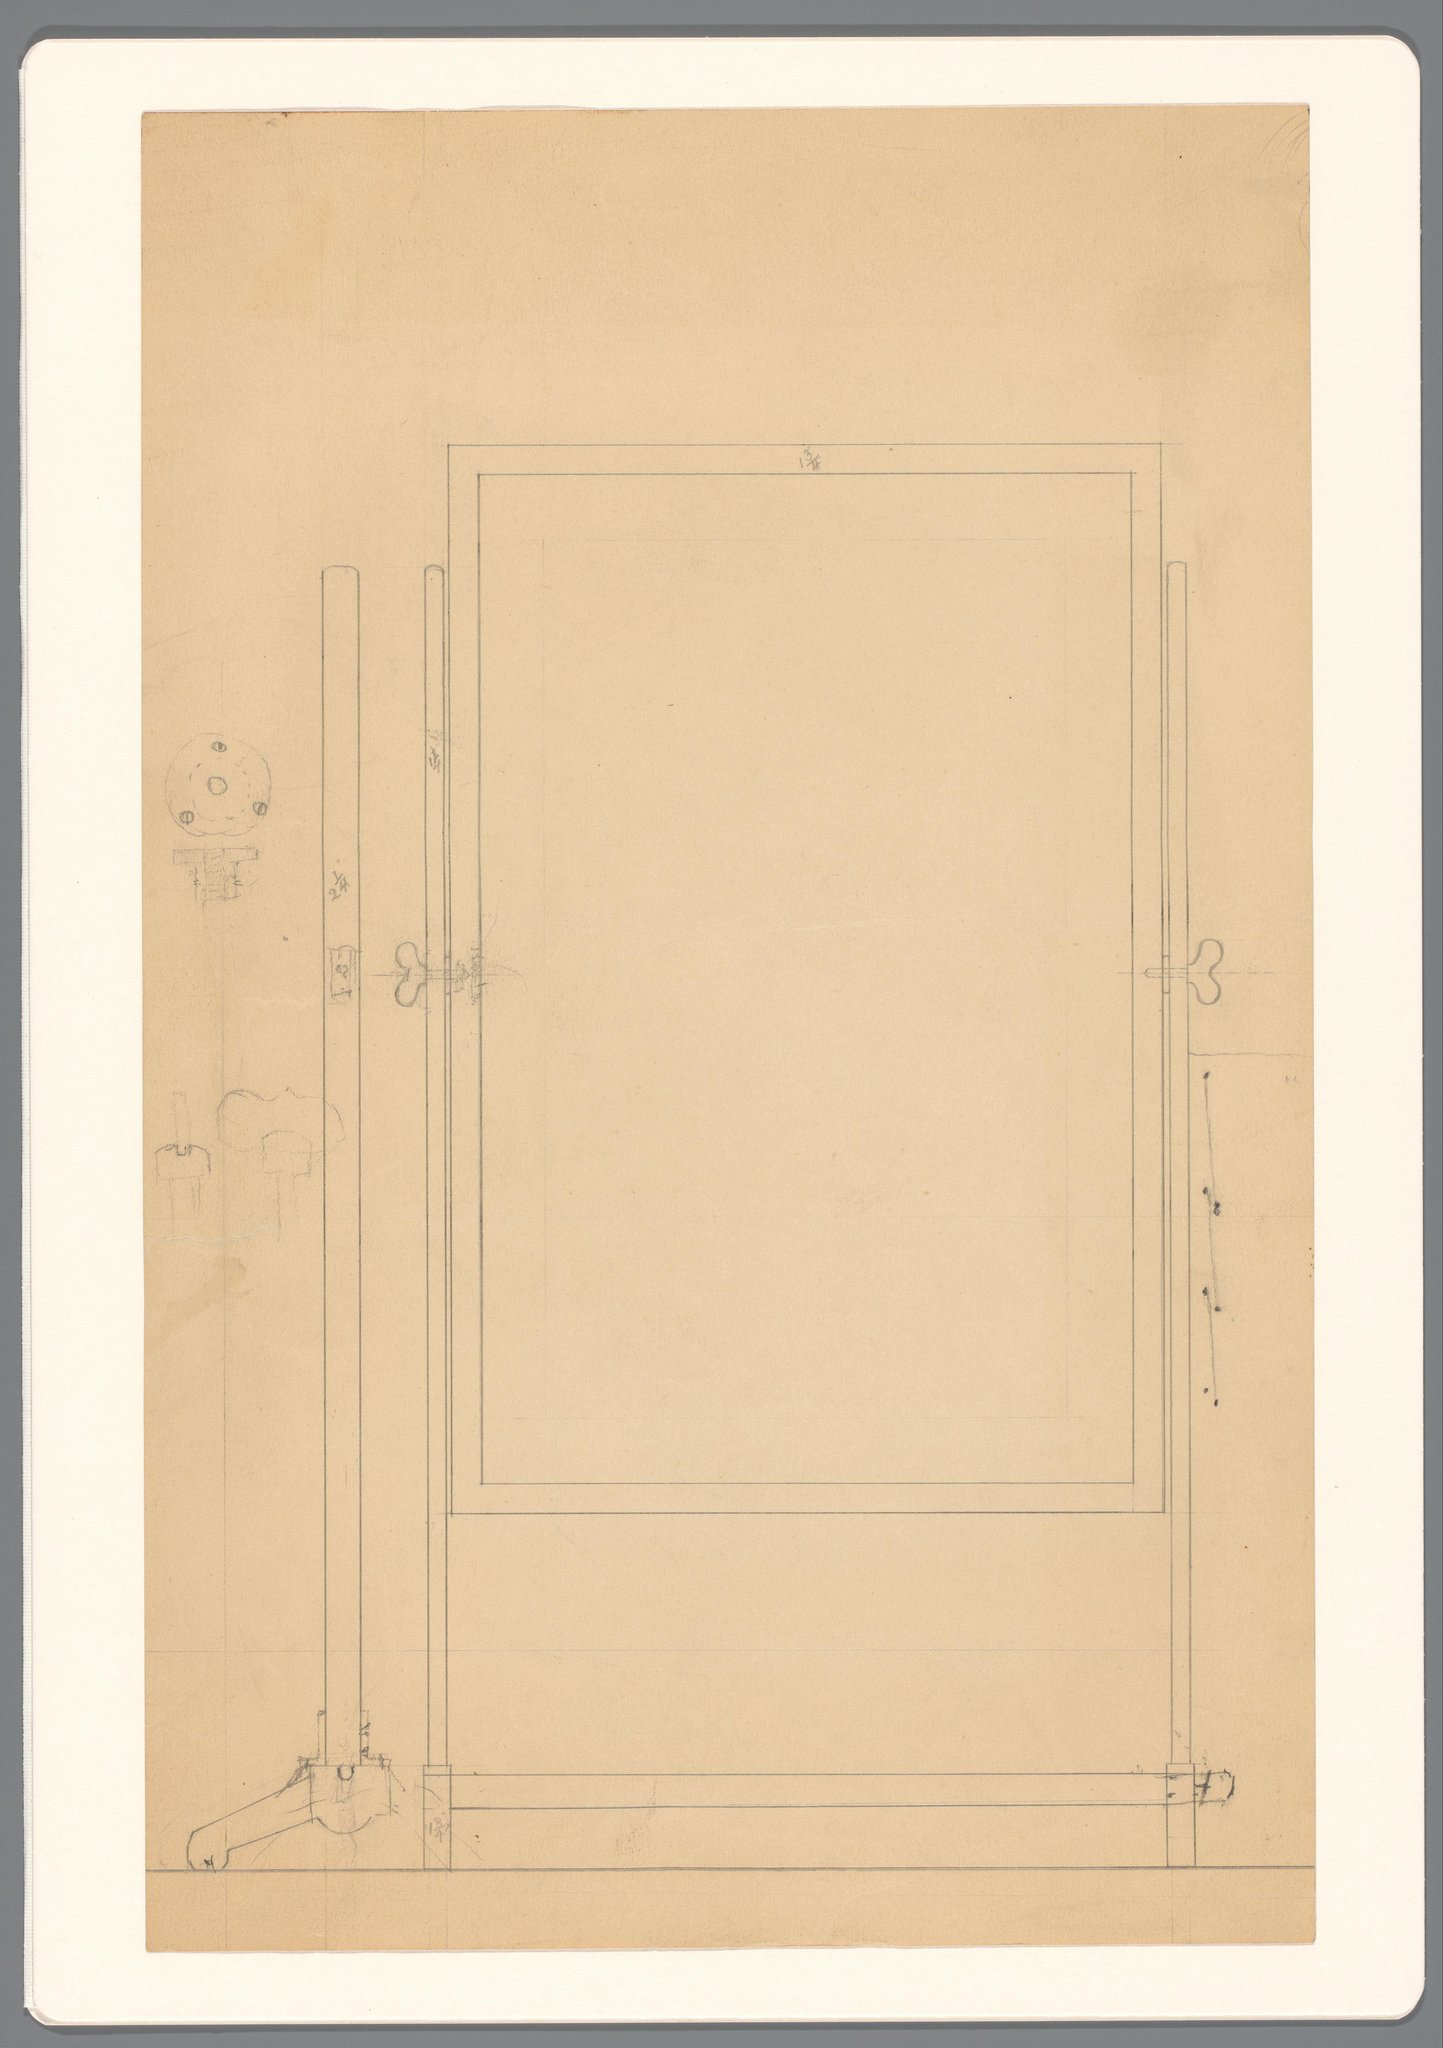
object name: drawing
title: Ontwerp voor een verstelbaar haardscherm, voor en zijaanzicht en details. Verso: Details van haardschermen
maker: b. winghofer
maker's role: draughtsman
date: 1852-1855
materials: graphite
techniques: drawing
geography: mainz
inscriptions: inscription: ‘2 ¼, 1 ¼, 1 ¾.’